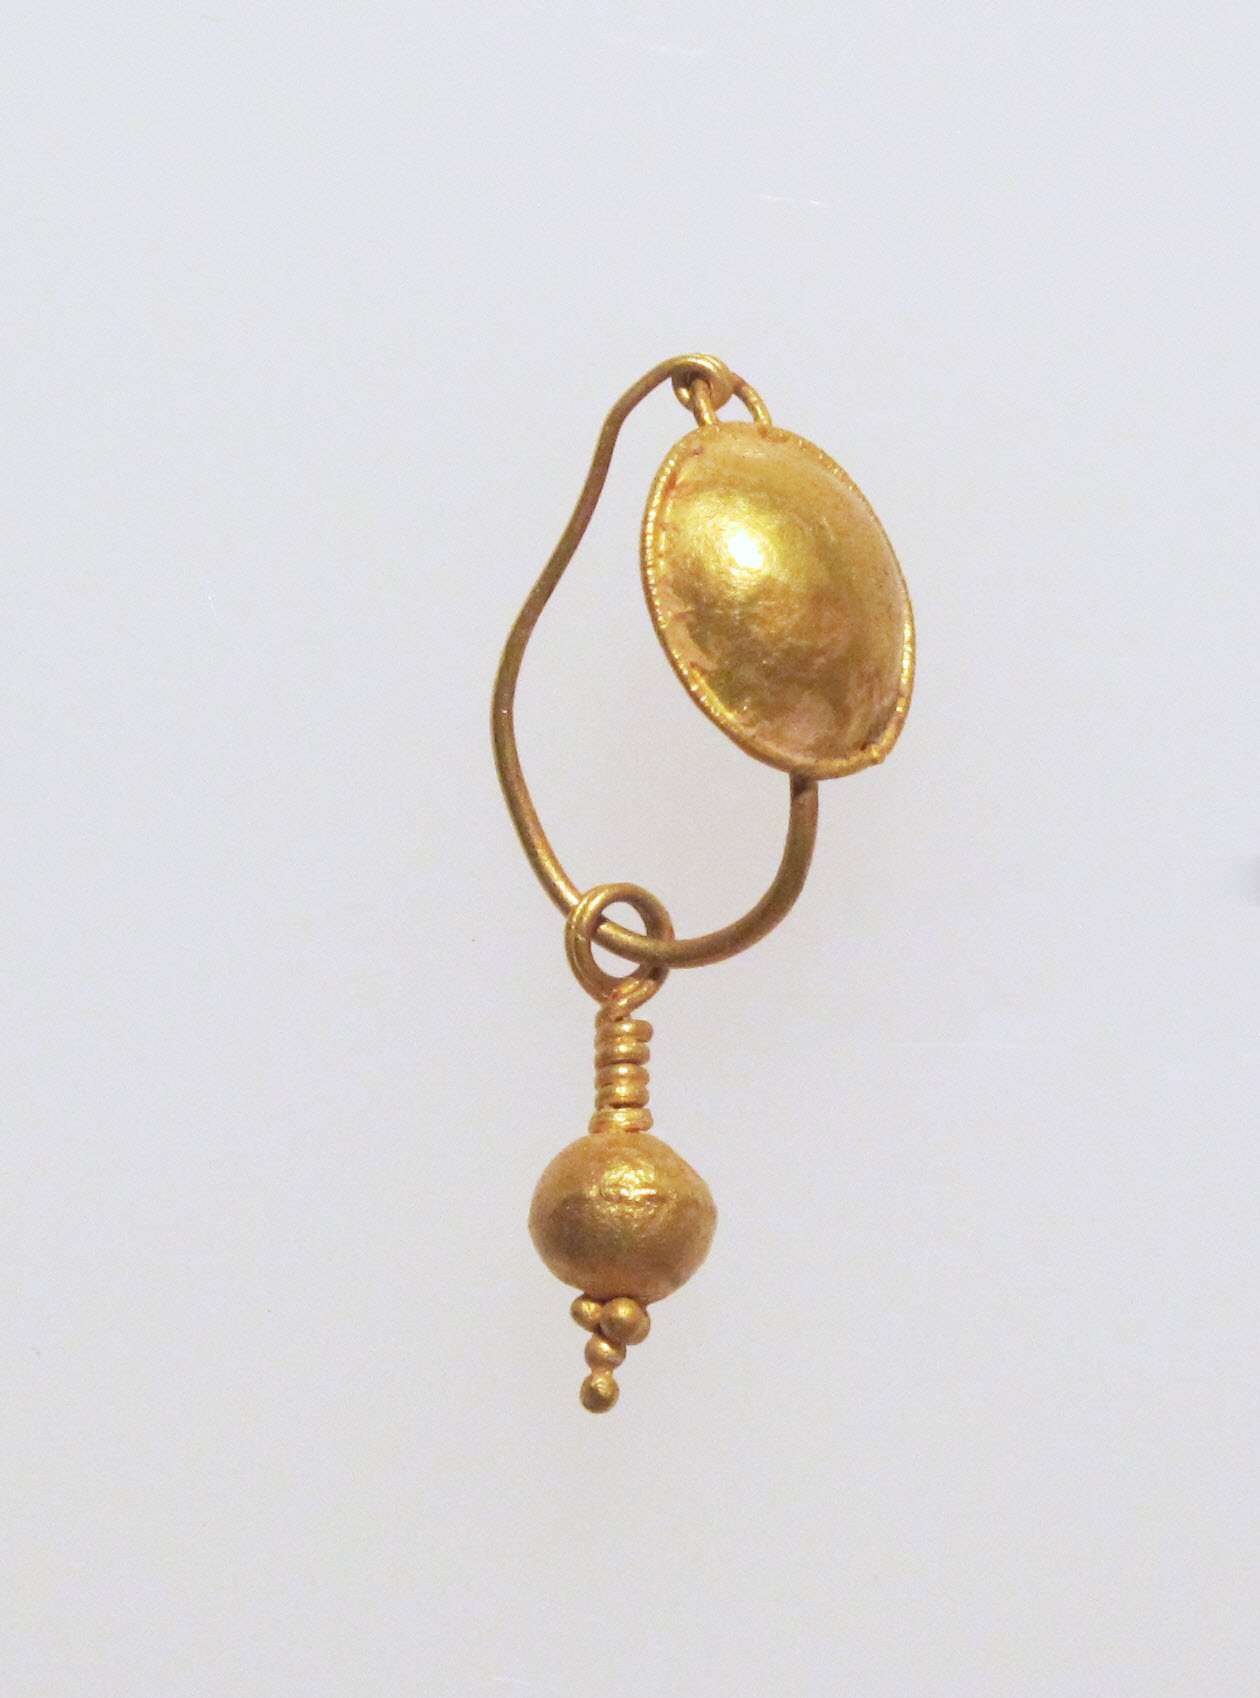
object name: earring with ball pendant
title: Gold earring with disc and pendant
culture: roman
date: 101-200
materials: gold